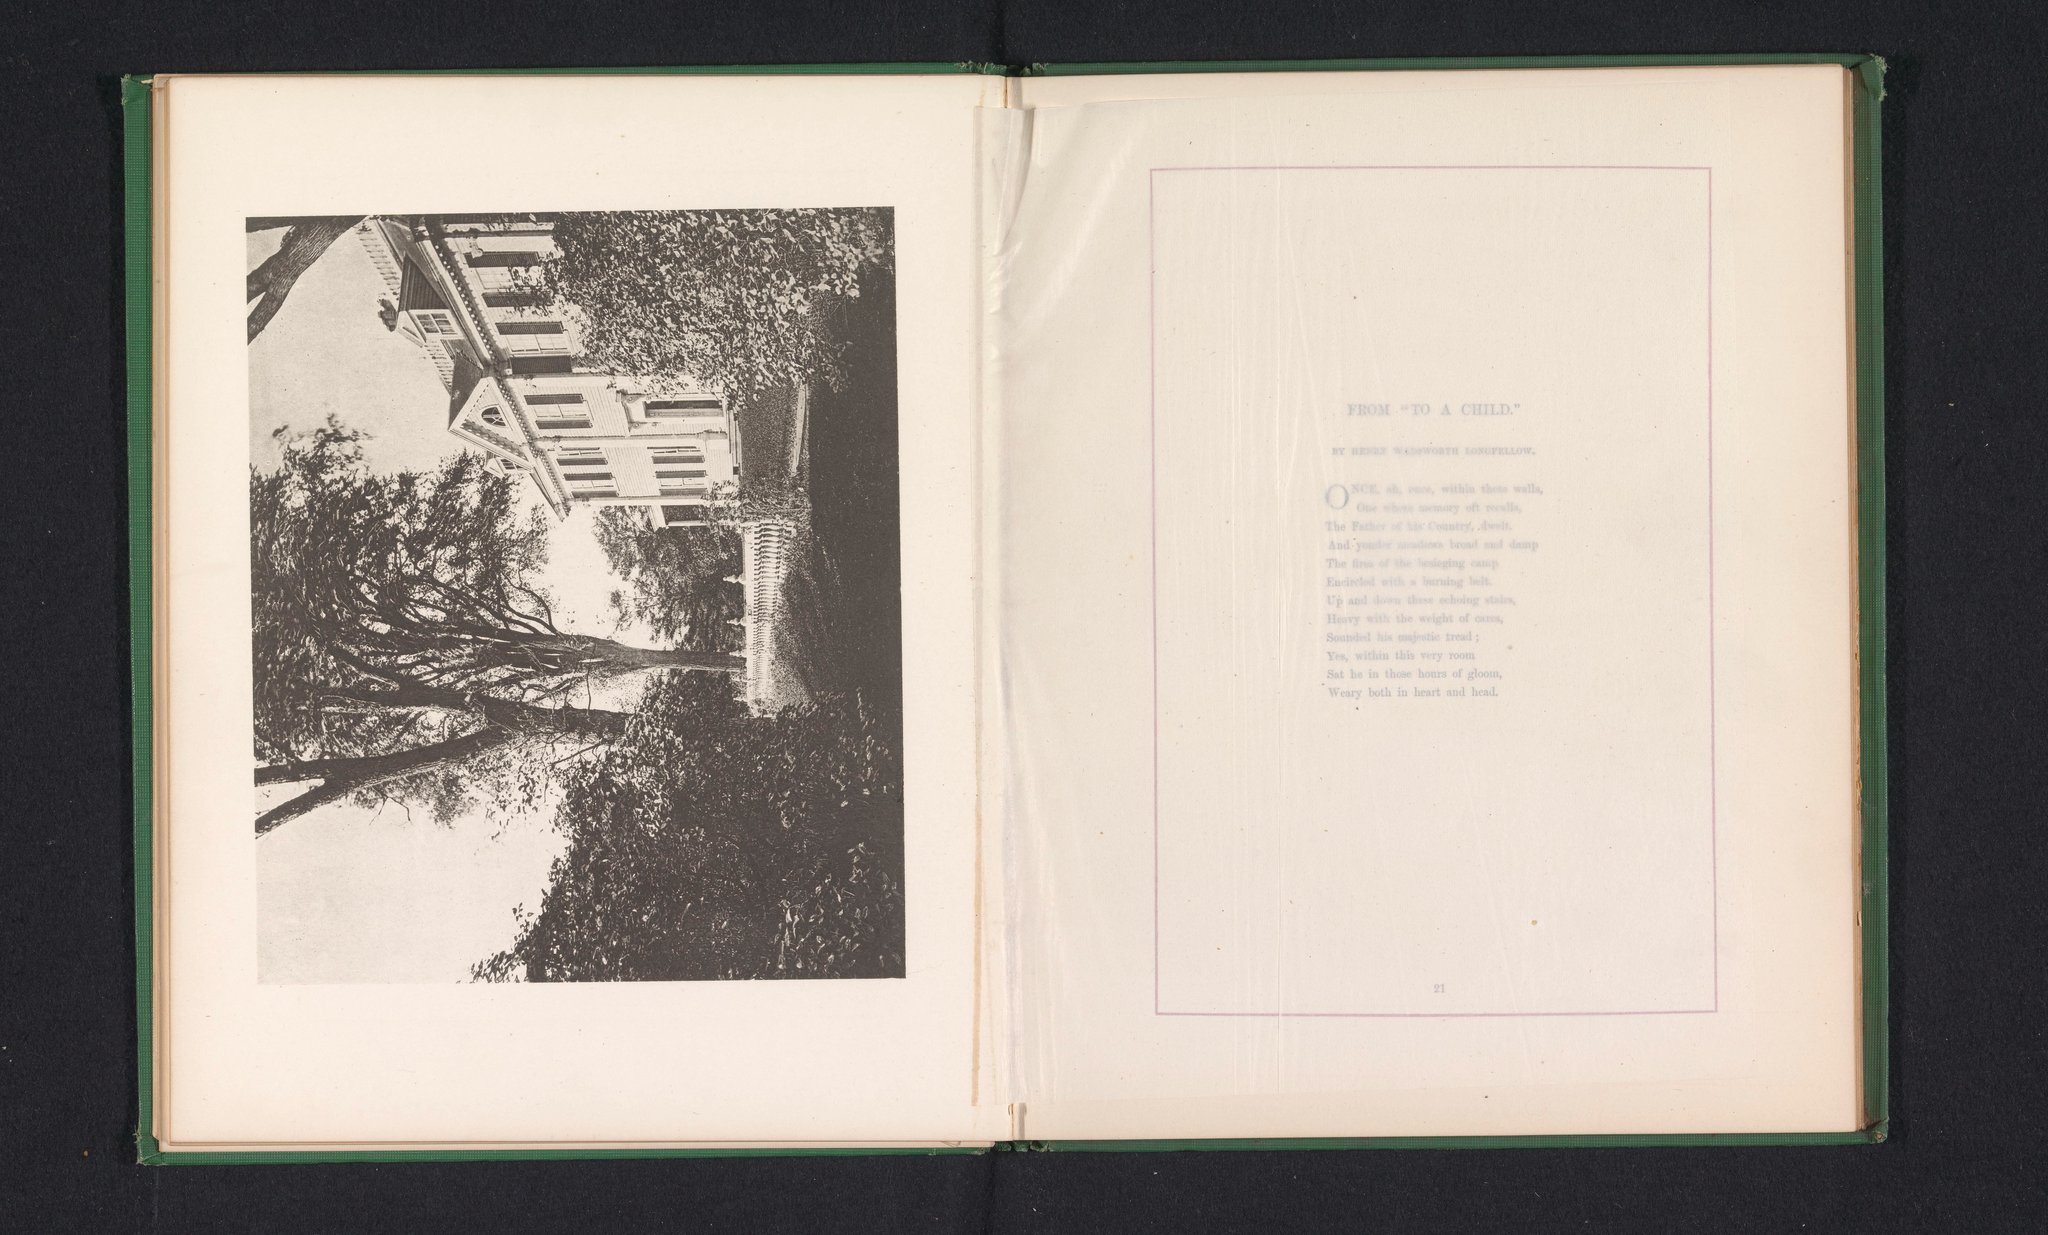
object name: page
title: Gezicht op het huis van Henry Wadsworth Longfellow te Cambridge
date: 1866-1876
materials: paper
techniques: photograph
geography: cambridge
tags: housing, façade (of house or building)